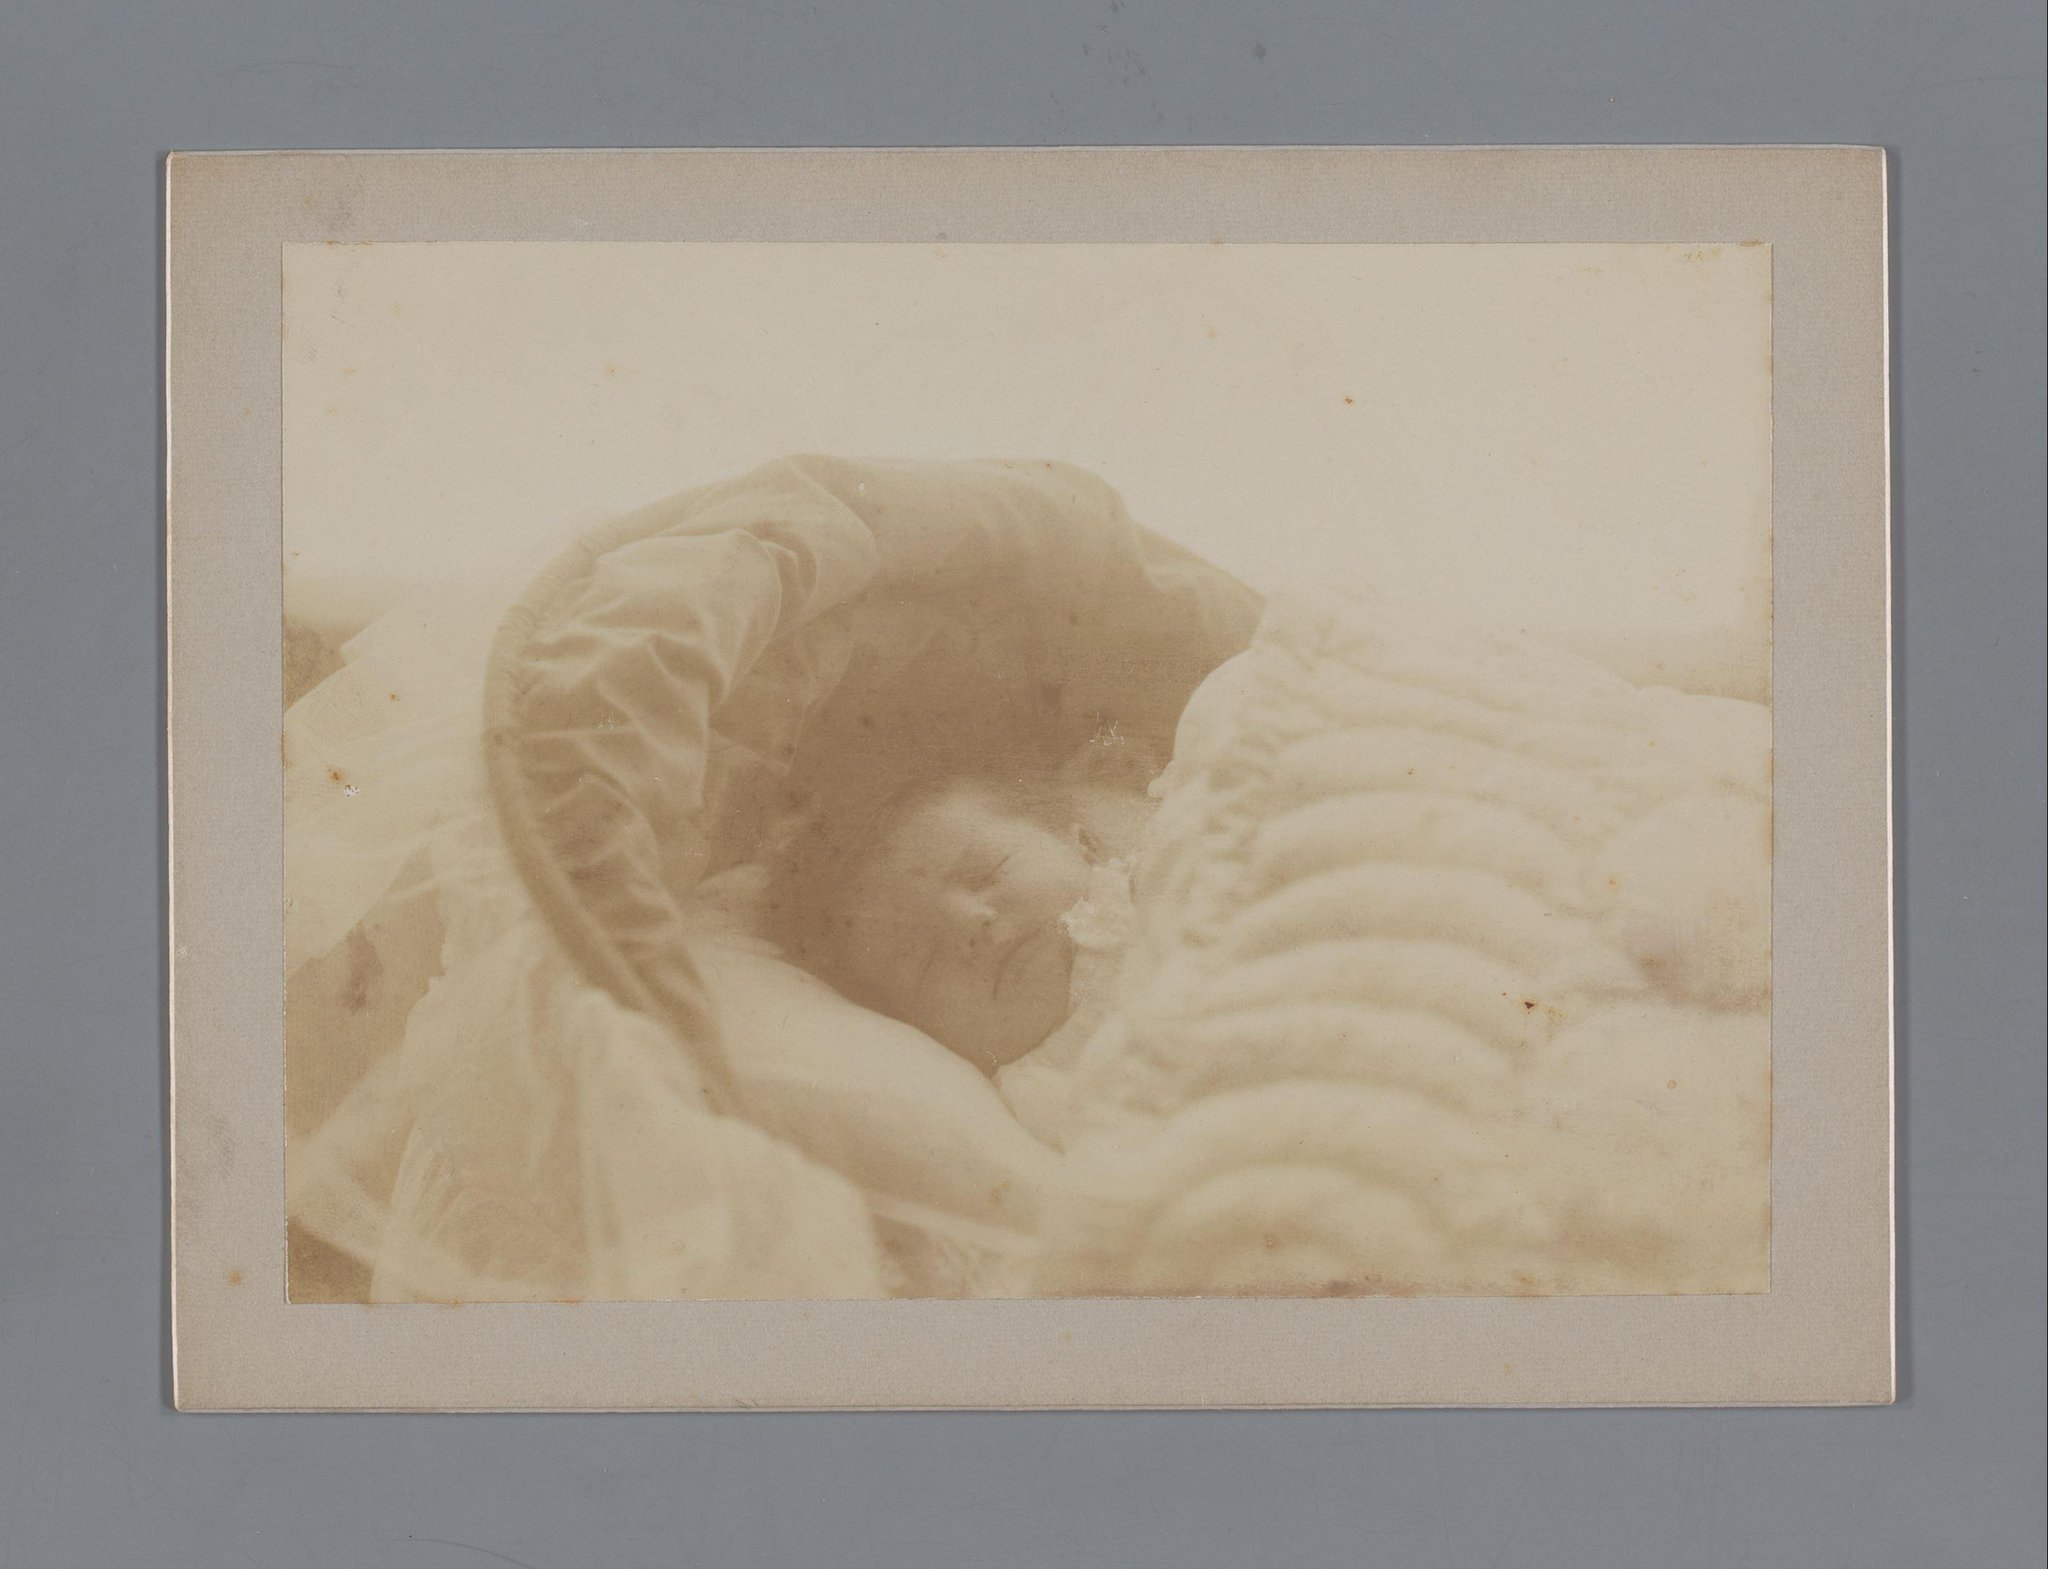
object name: photograph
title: Portret van Johanna Geertruida van der Waals slapend in de wieg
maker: johannes diderik van der waals (1873-1971)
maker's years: 1873-1971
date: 1903-1905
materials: cardboard, photographic support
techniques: collodion silver print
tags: historical persons, cradle, crib, infant, baby